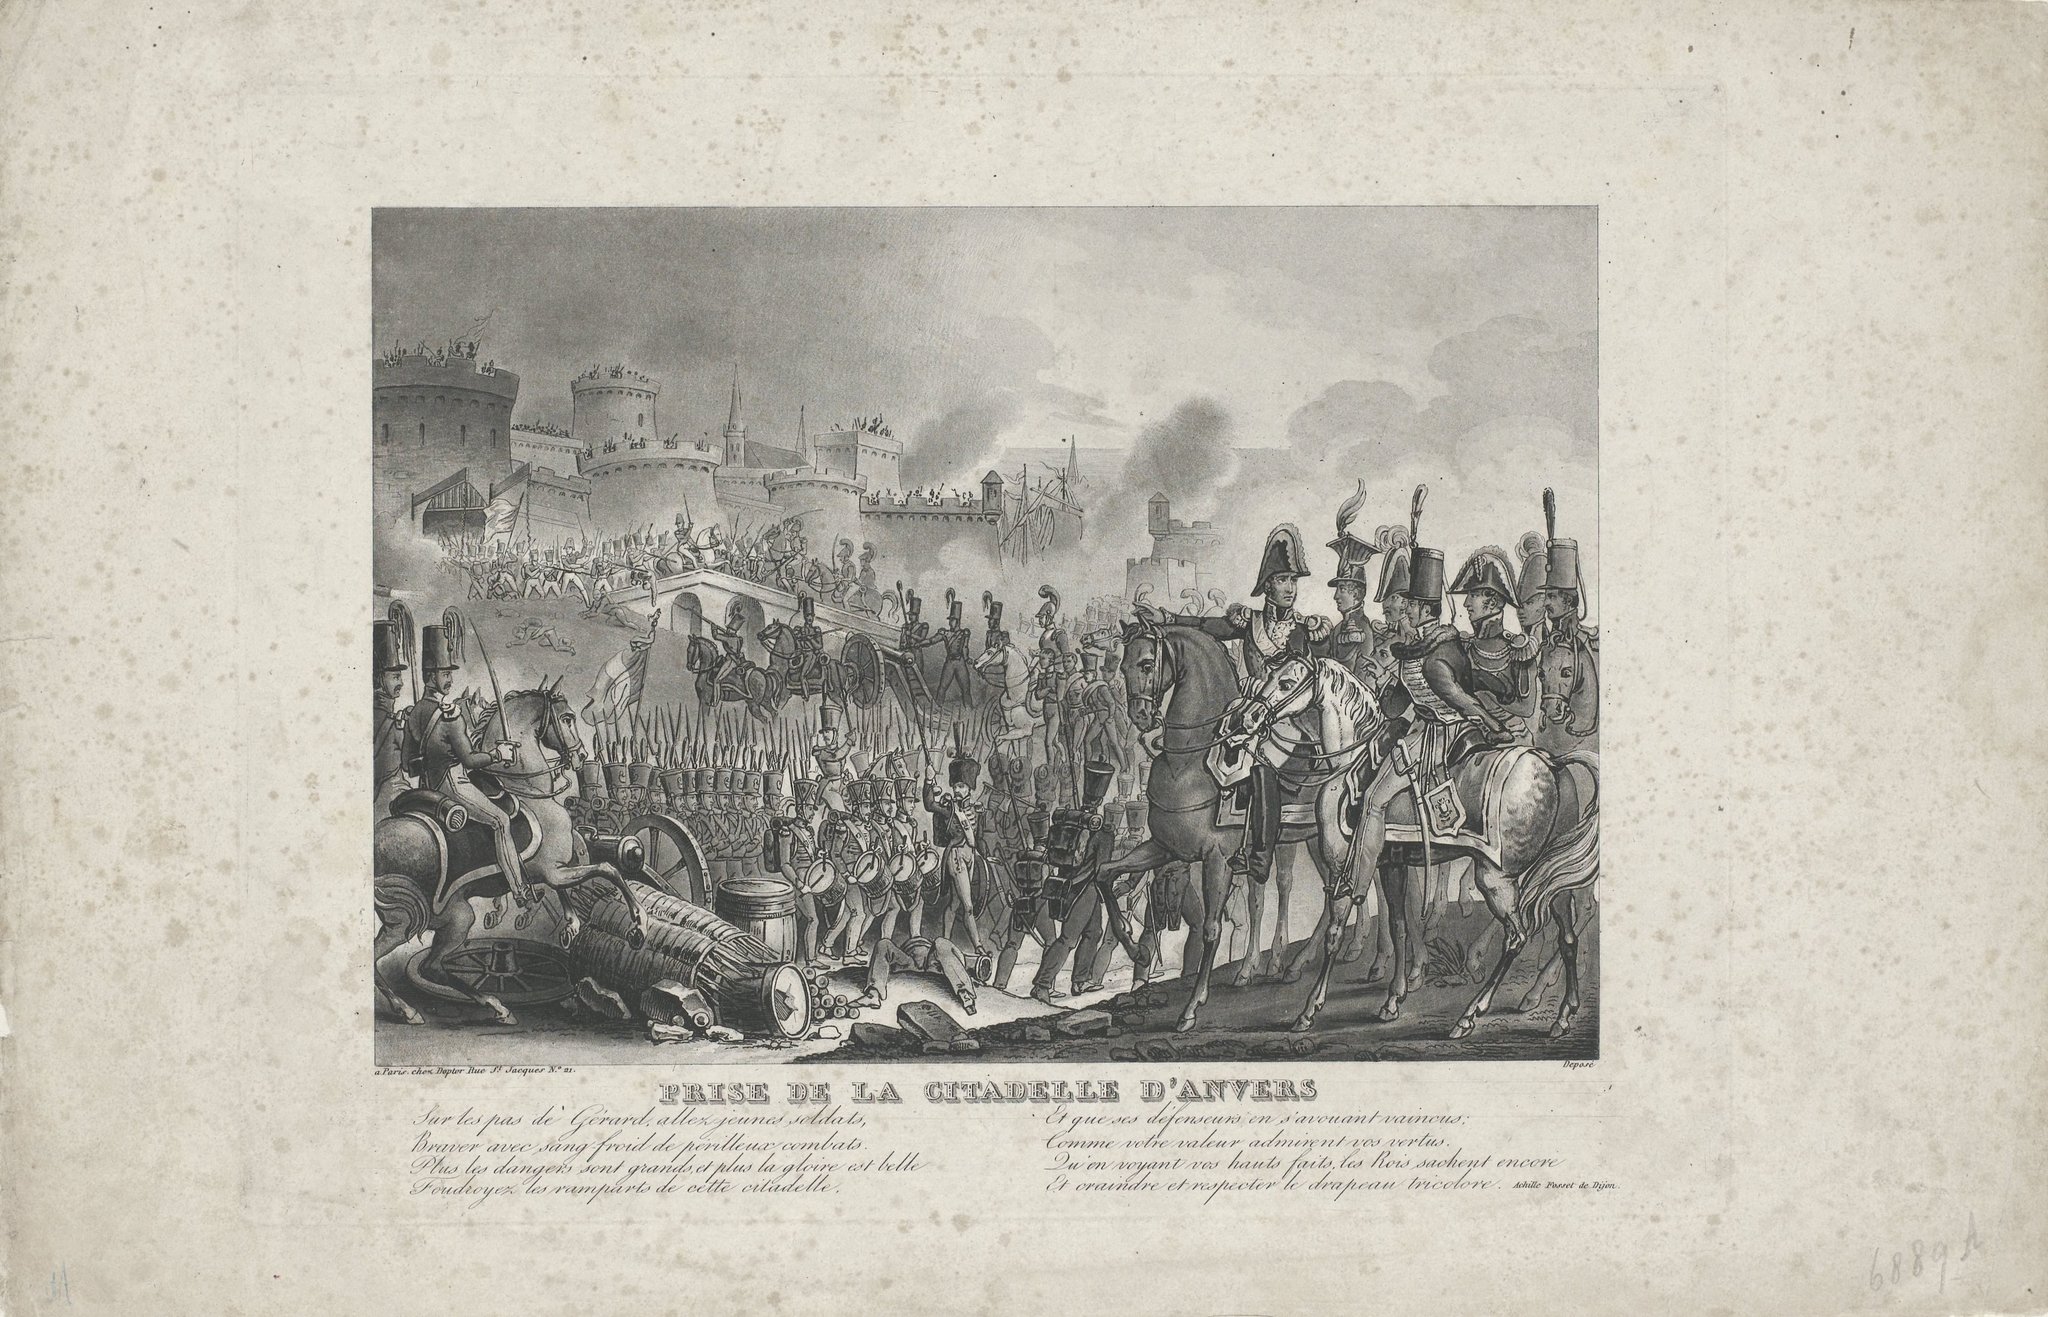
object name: print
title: Inname van de Citadel van Antwerpen, 1832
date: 1832-1835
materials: paper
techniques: lithograph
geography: dijon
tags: attack ~ siege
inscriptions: : ‘Deposé’, collector's mark: Lugt 2228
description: Gefantaseerde voorstelling van de verovering van de Citadel van Antwerpen door het Franse leger, december 1832. Op de voorgrond de Franse generaal Gérard te paard die leiding geeft aan de belegerende troepen. Op de achtergrond een vesting met torens en muren met kantelen. In het onderschrift twee vierregelige verzen in het Frans.